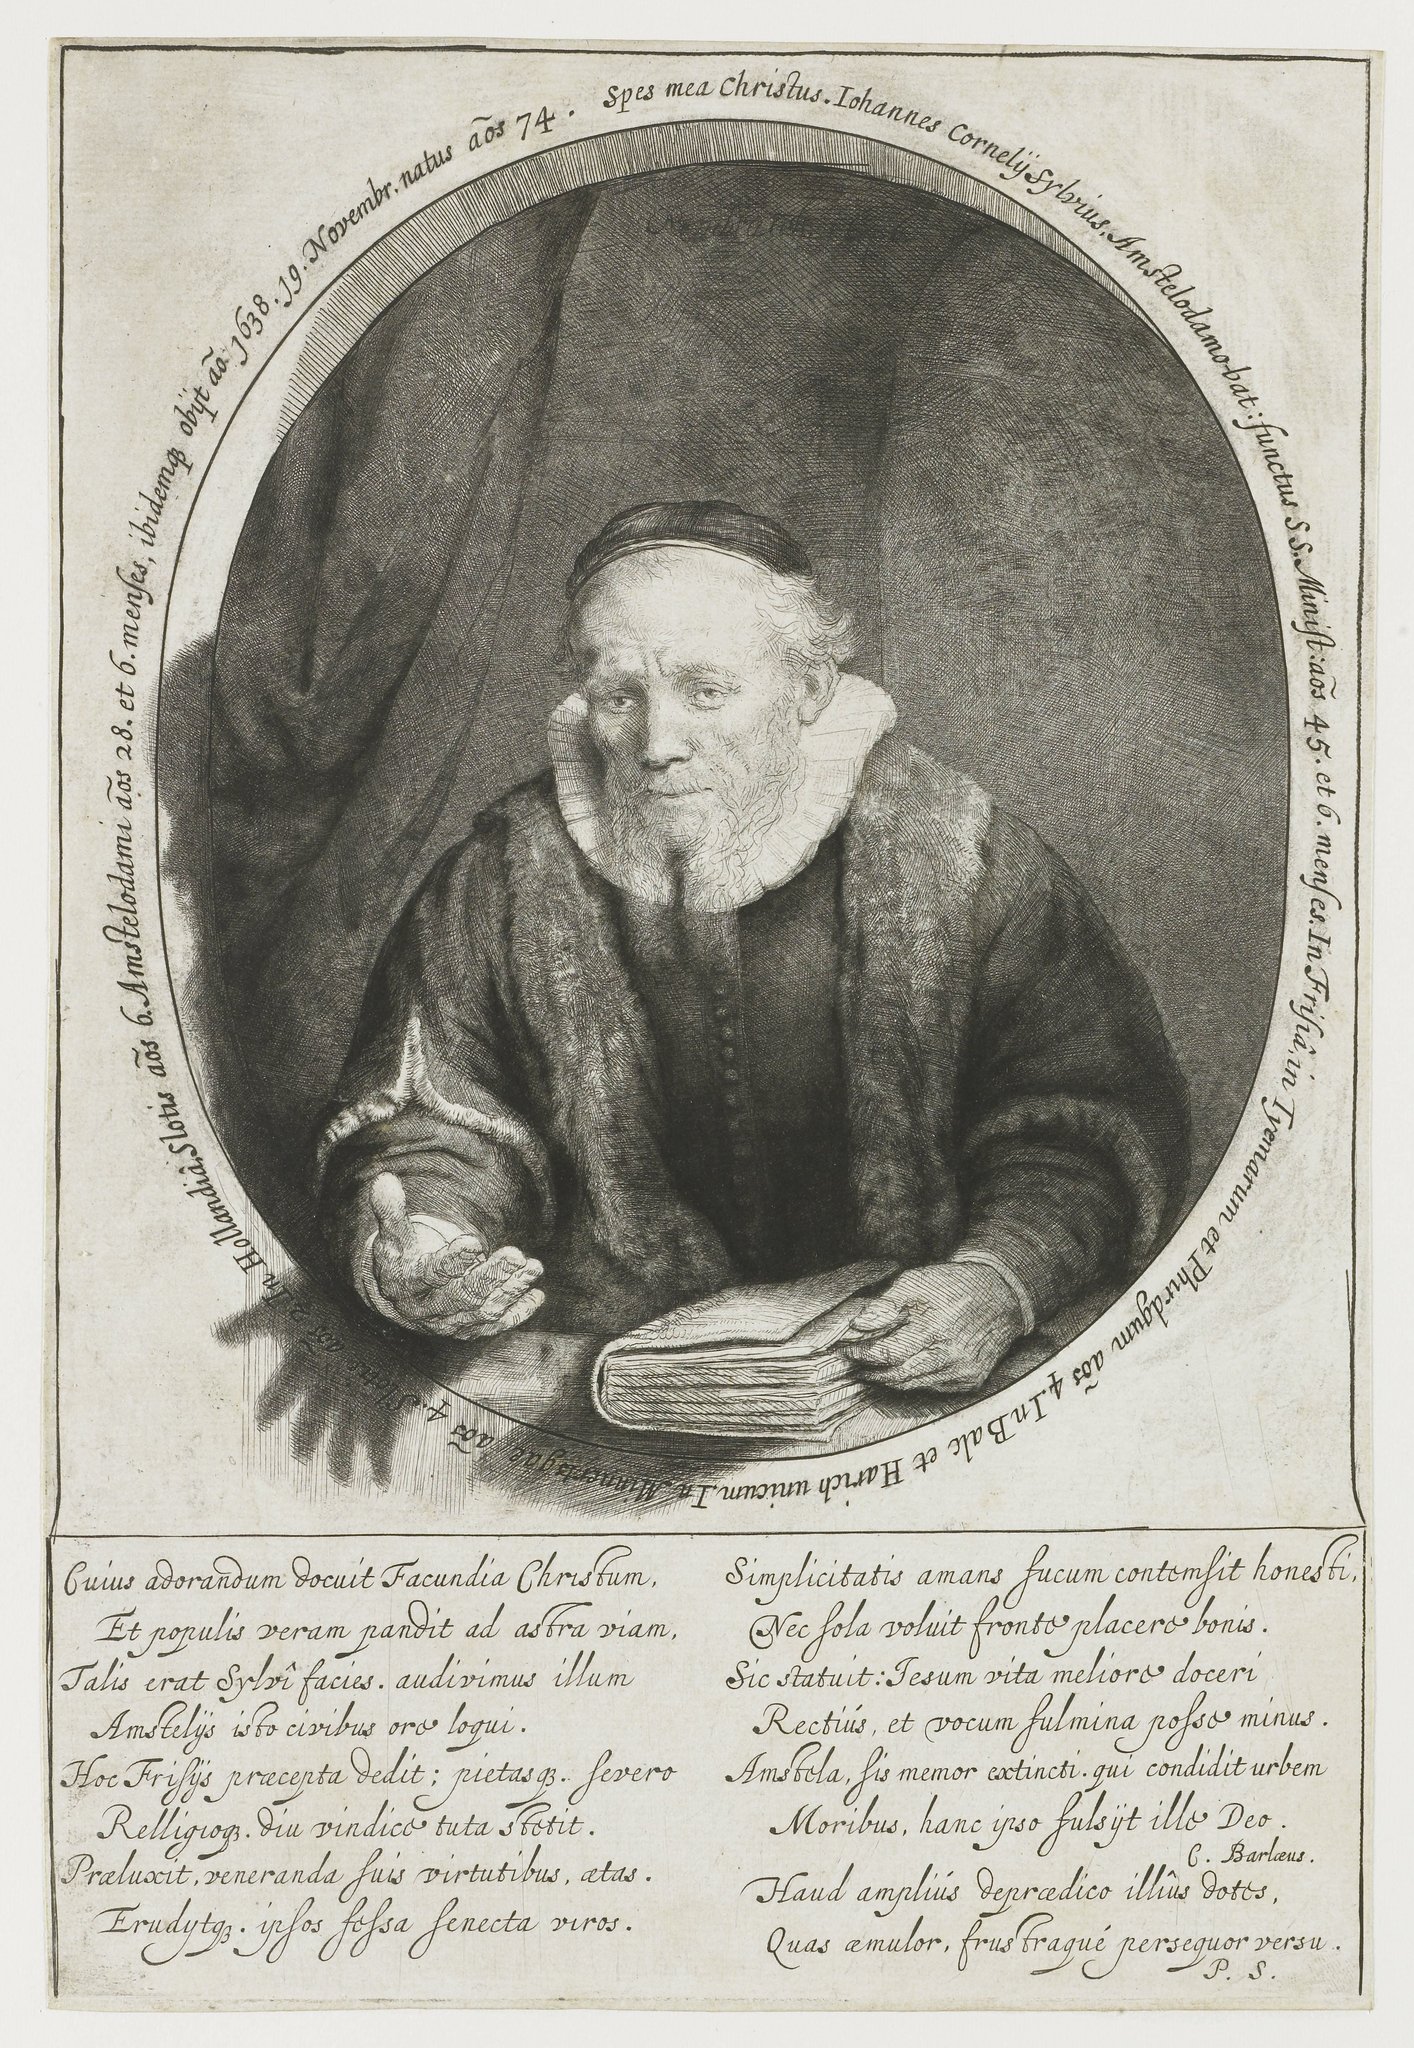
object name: print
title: Jan Cornelis Sylvius, preacher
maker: rembrandt van rijn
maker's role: draughtsman, painter, print maker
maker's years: 1606-1669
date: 1646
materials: paper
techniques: drypoint, etching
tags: amsterdam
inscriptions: signature and date: ‘Rembrandt 1646’